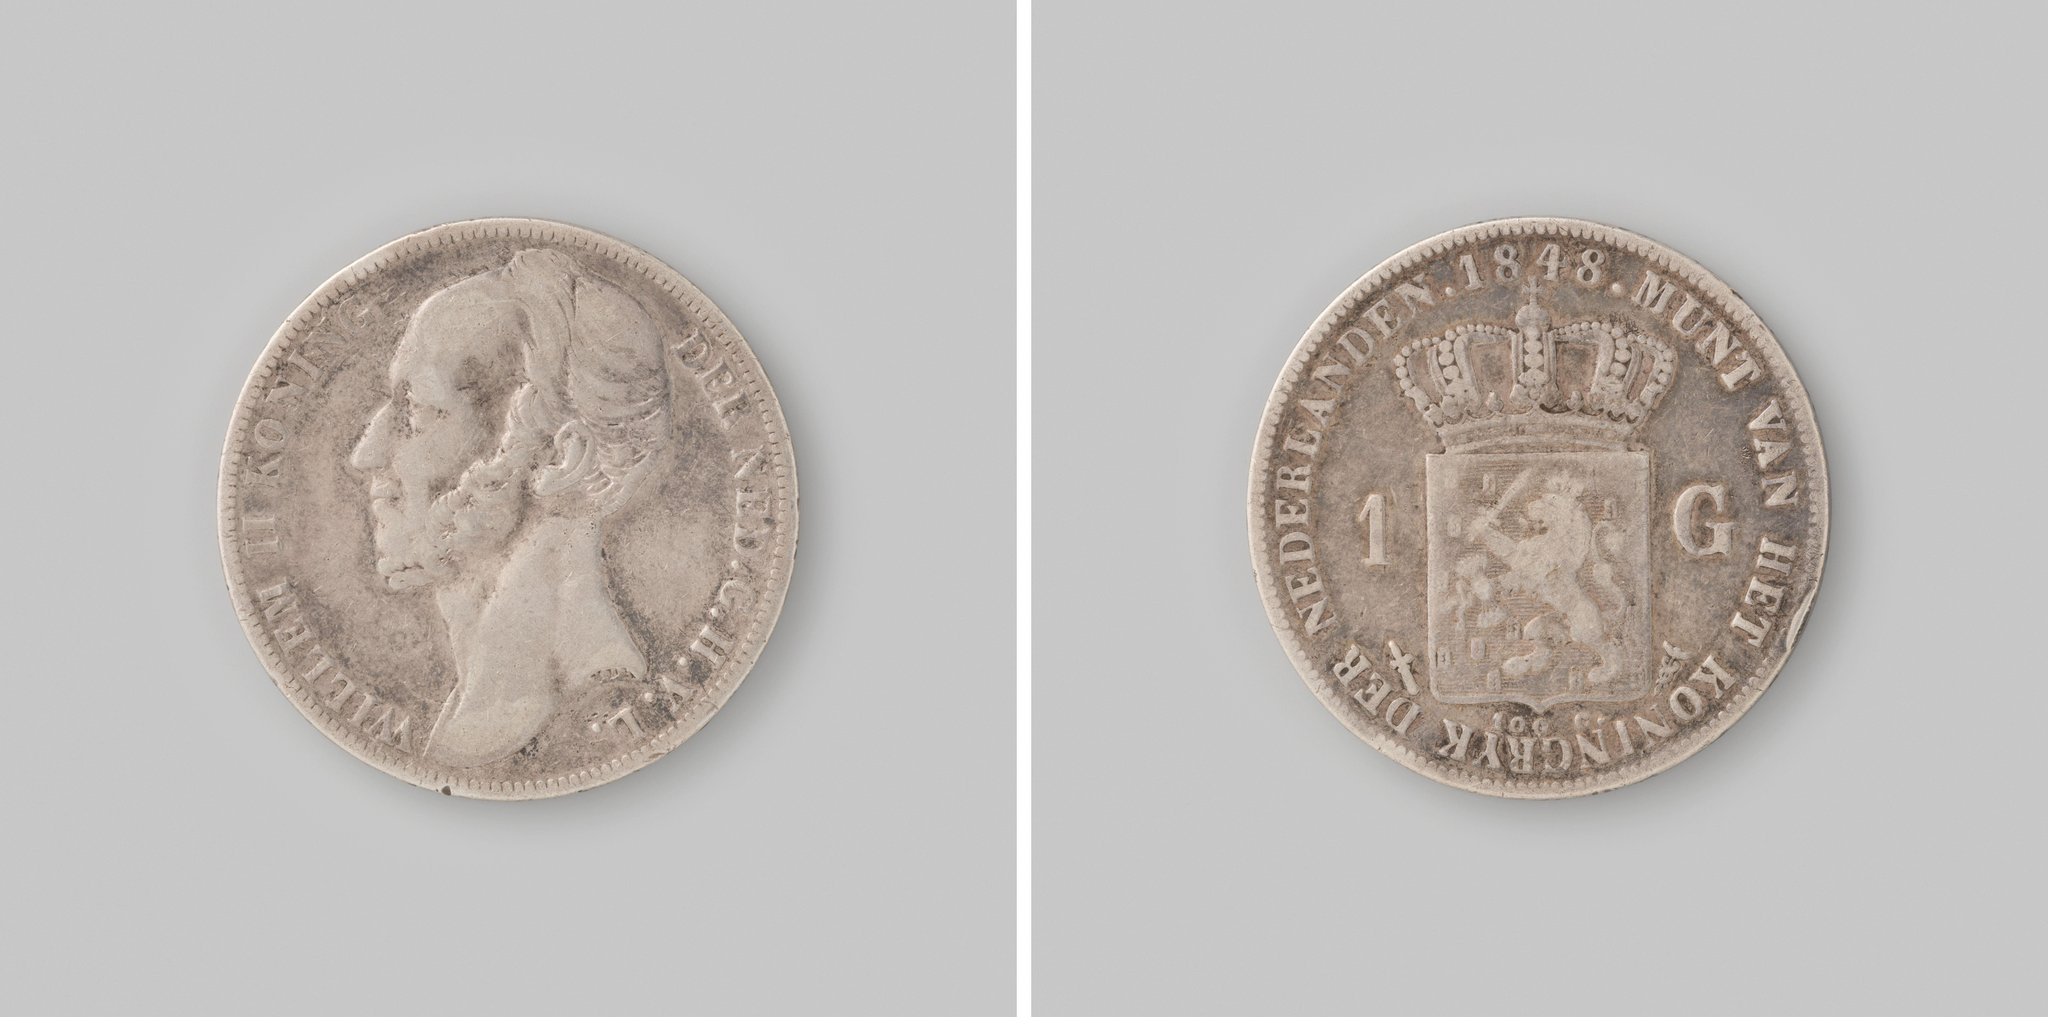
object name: coin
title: Nederland, gulden, 1848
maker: william ii of the netherlands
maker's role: koning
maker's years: 1792-1849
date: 1848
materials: silver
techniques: striking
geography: utrecht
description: Zilveren munt. Voorzijde: borstbeeld naar links. Keerzijde: tussen waarde-aanduiding 1 G gekroond rijkswapenschild. Jaartal boven kroon. Randschrift.